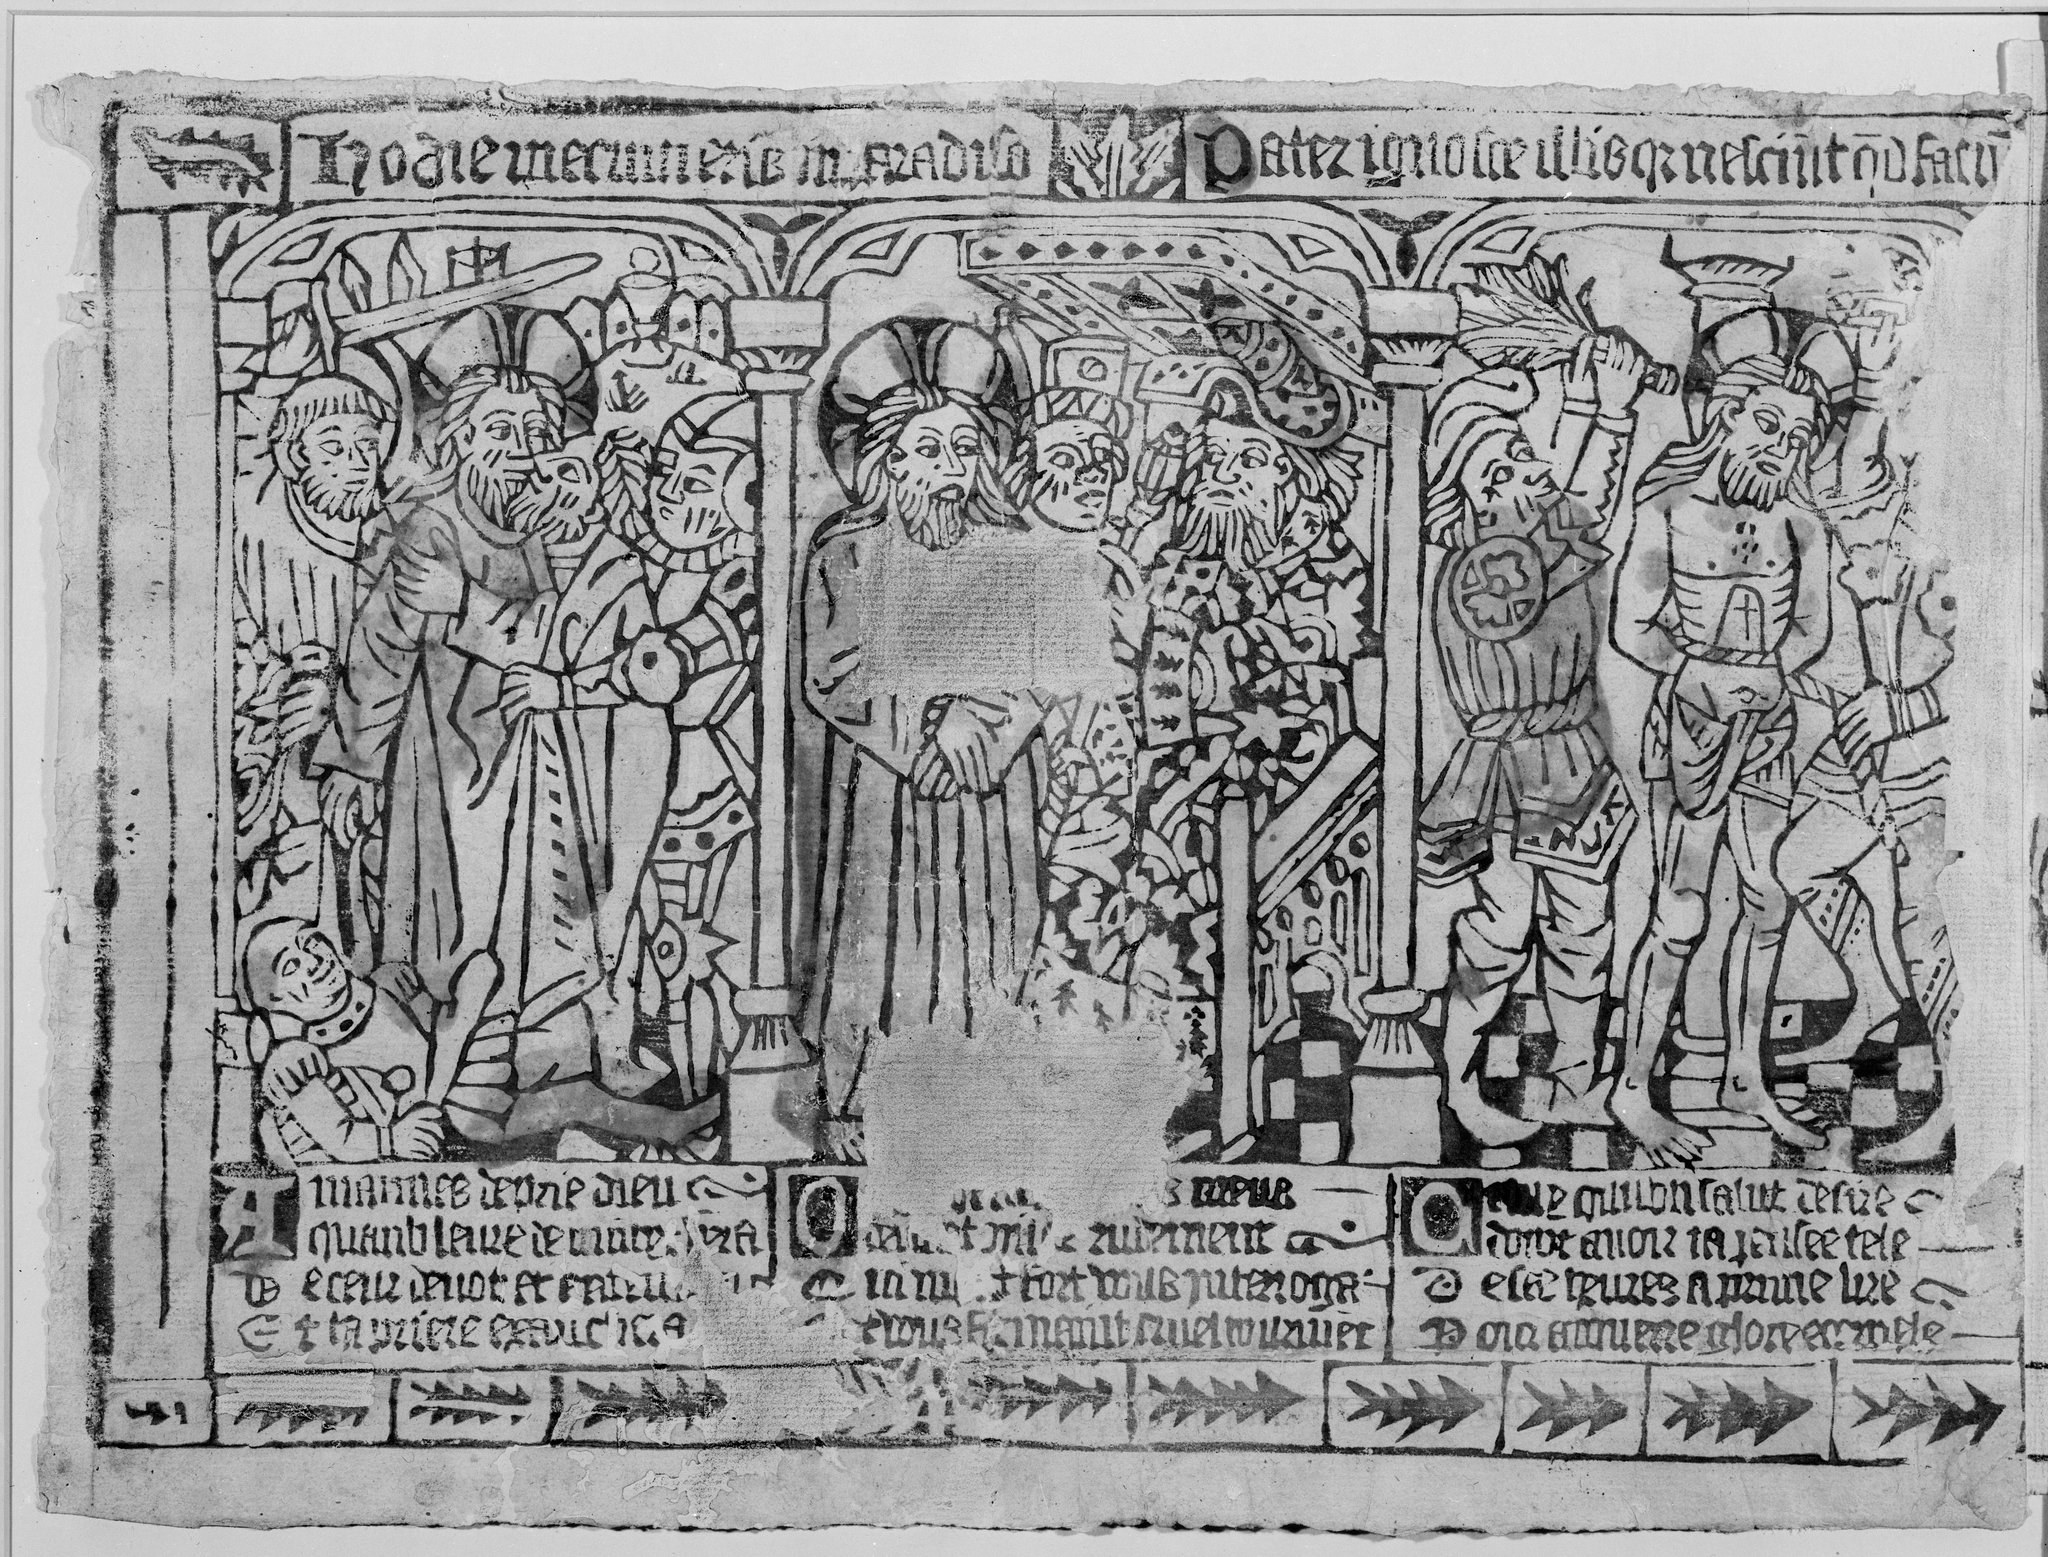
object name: print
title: Three Fragments of a Passion Frieze: The Kiss of Judas, Christ before Pilate, and the Flagellation; The Crucifixion and the Descent from the Cross; The Entombment and the Resurrection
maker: anonymous, french, amiens, 15th century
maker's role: artist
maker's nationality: french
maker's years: 1400-1500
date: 1460-1469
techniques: hand coloring, woodcut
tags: christ,judas,entombment